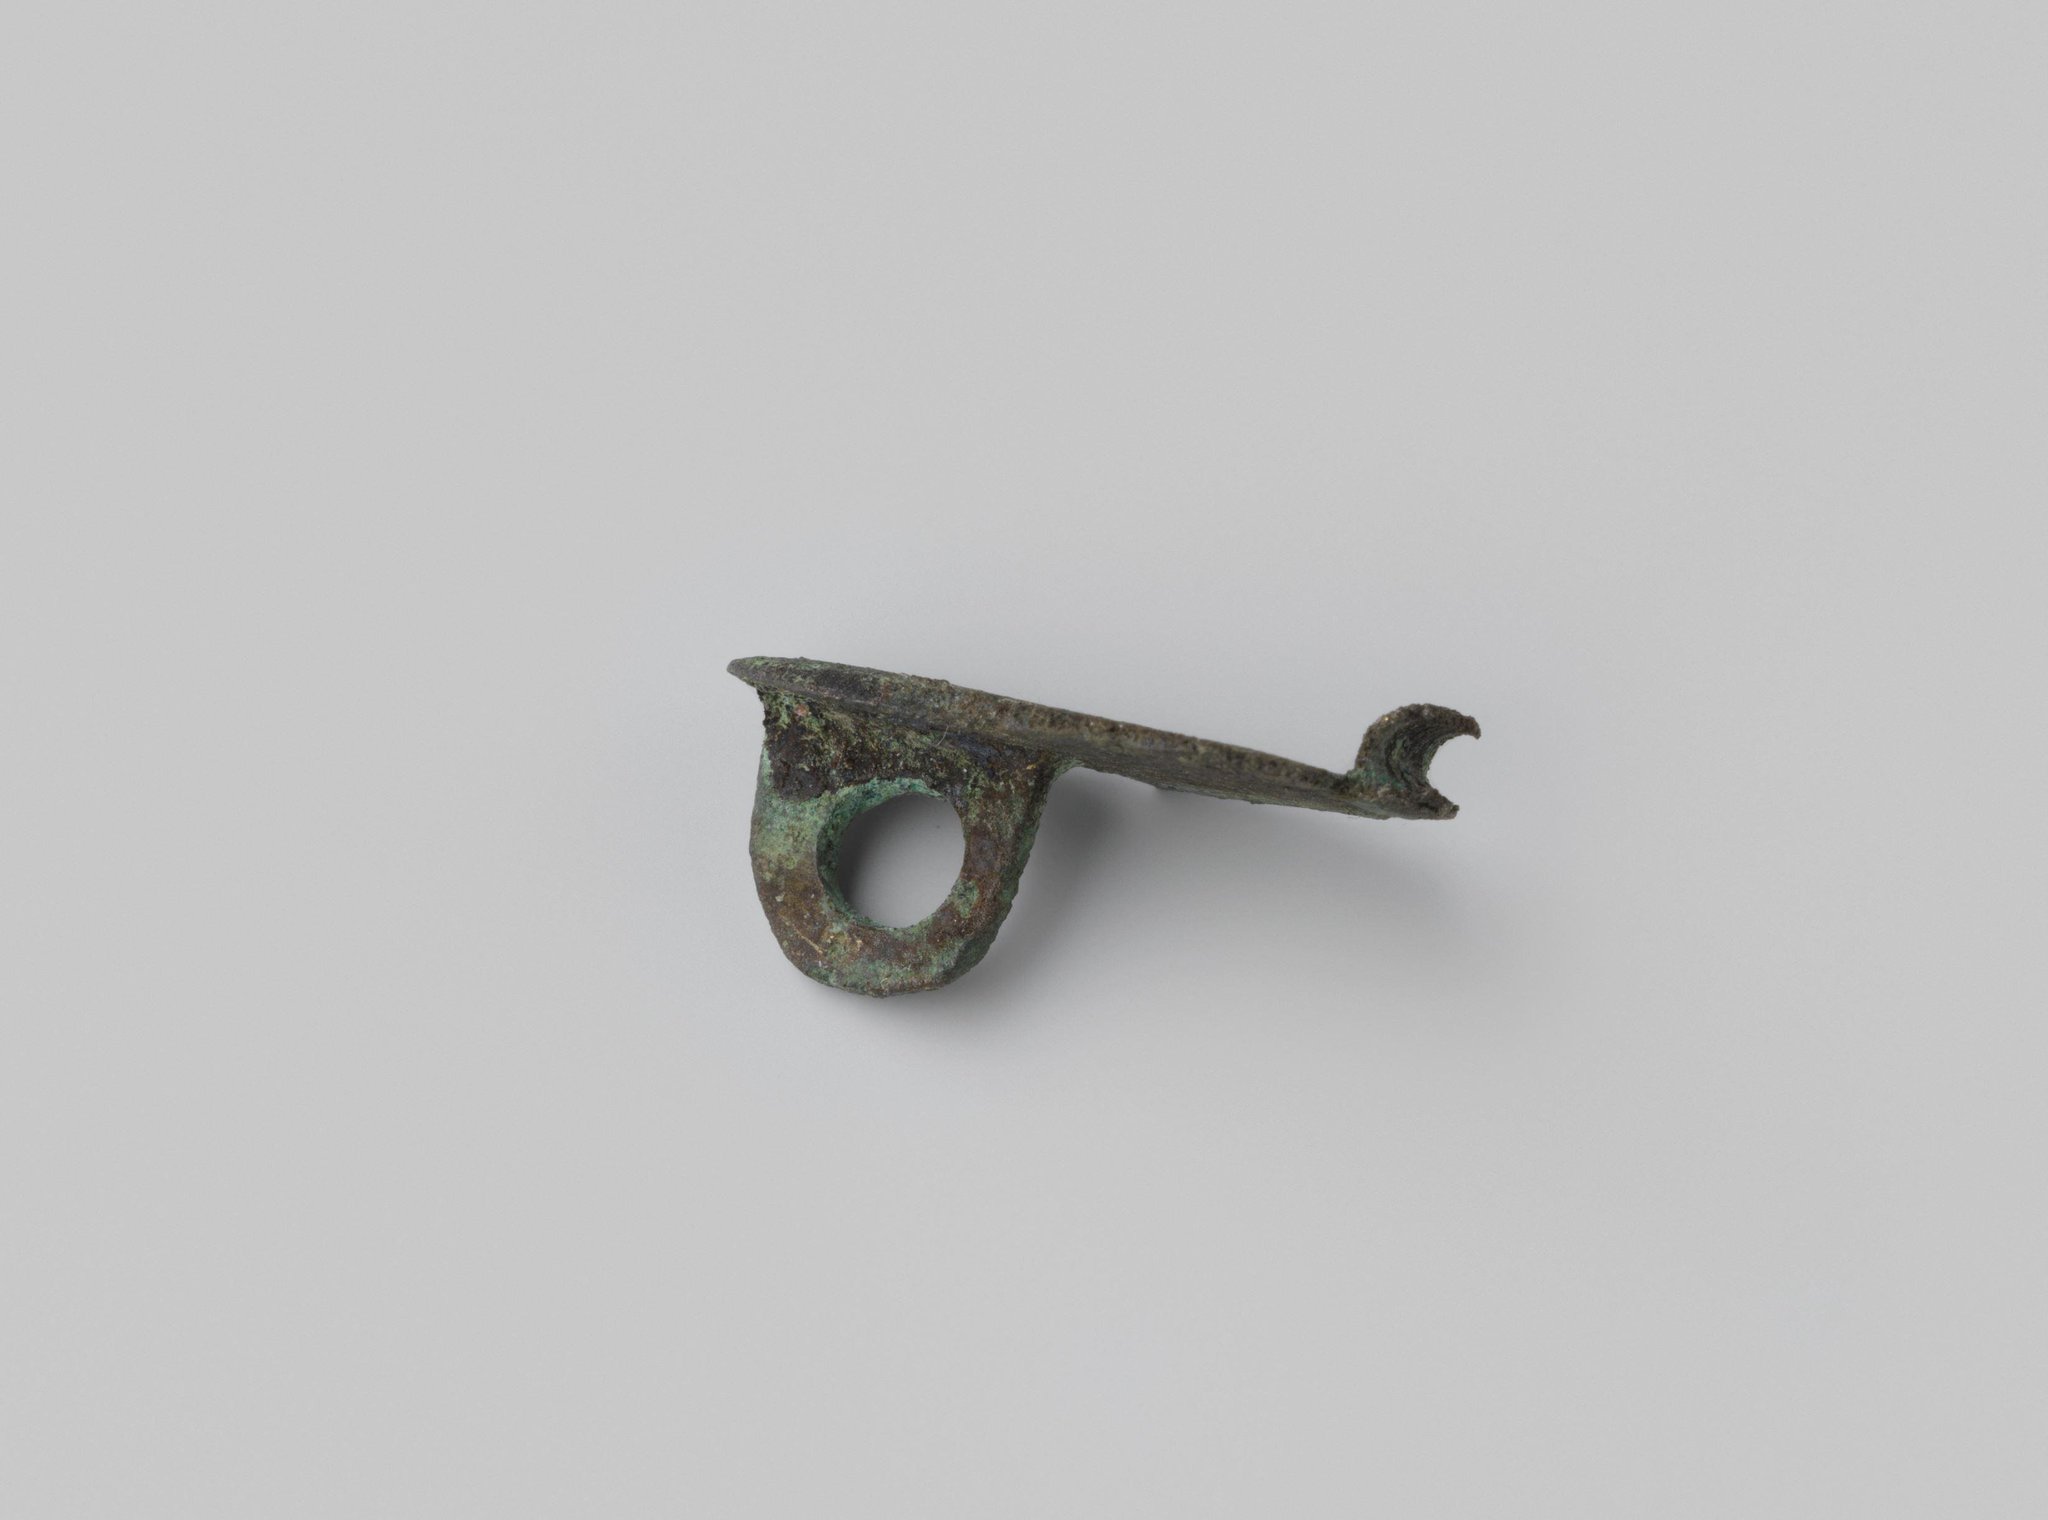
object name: clasp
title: Sluithaak uit het wrak van de Oost-Indiëvaarder Hollandia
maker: Anonymous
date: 1700-1743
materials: copper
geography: netherlands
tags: verenigde oostindische compagnie, hollandia (schip), annet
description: Locks, fastenings and accessories, clasp; eroded: flate plate, rectangular, one semicircular end with vertical pierced projection underneath, raised lug at other end.